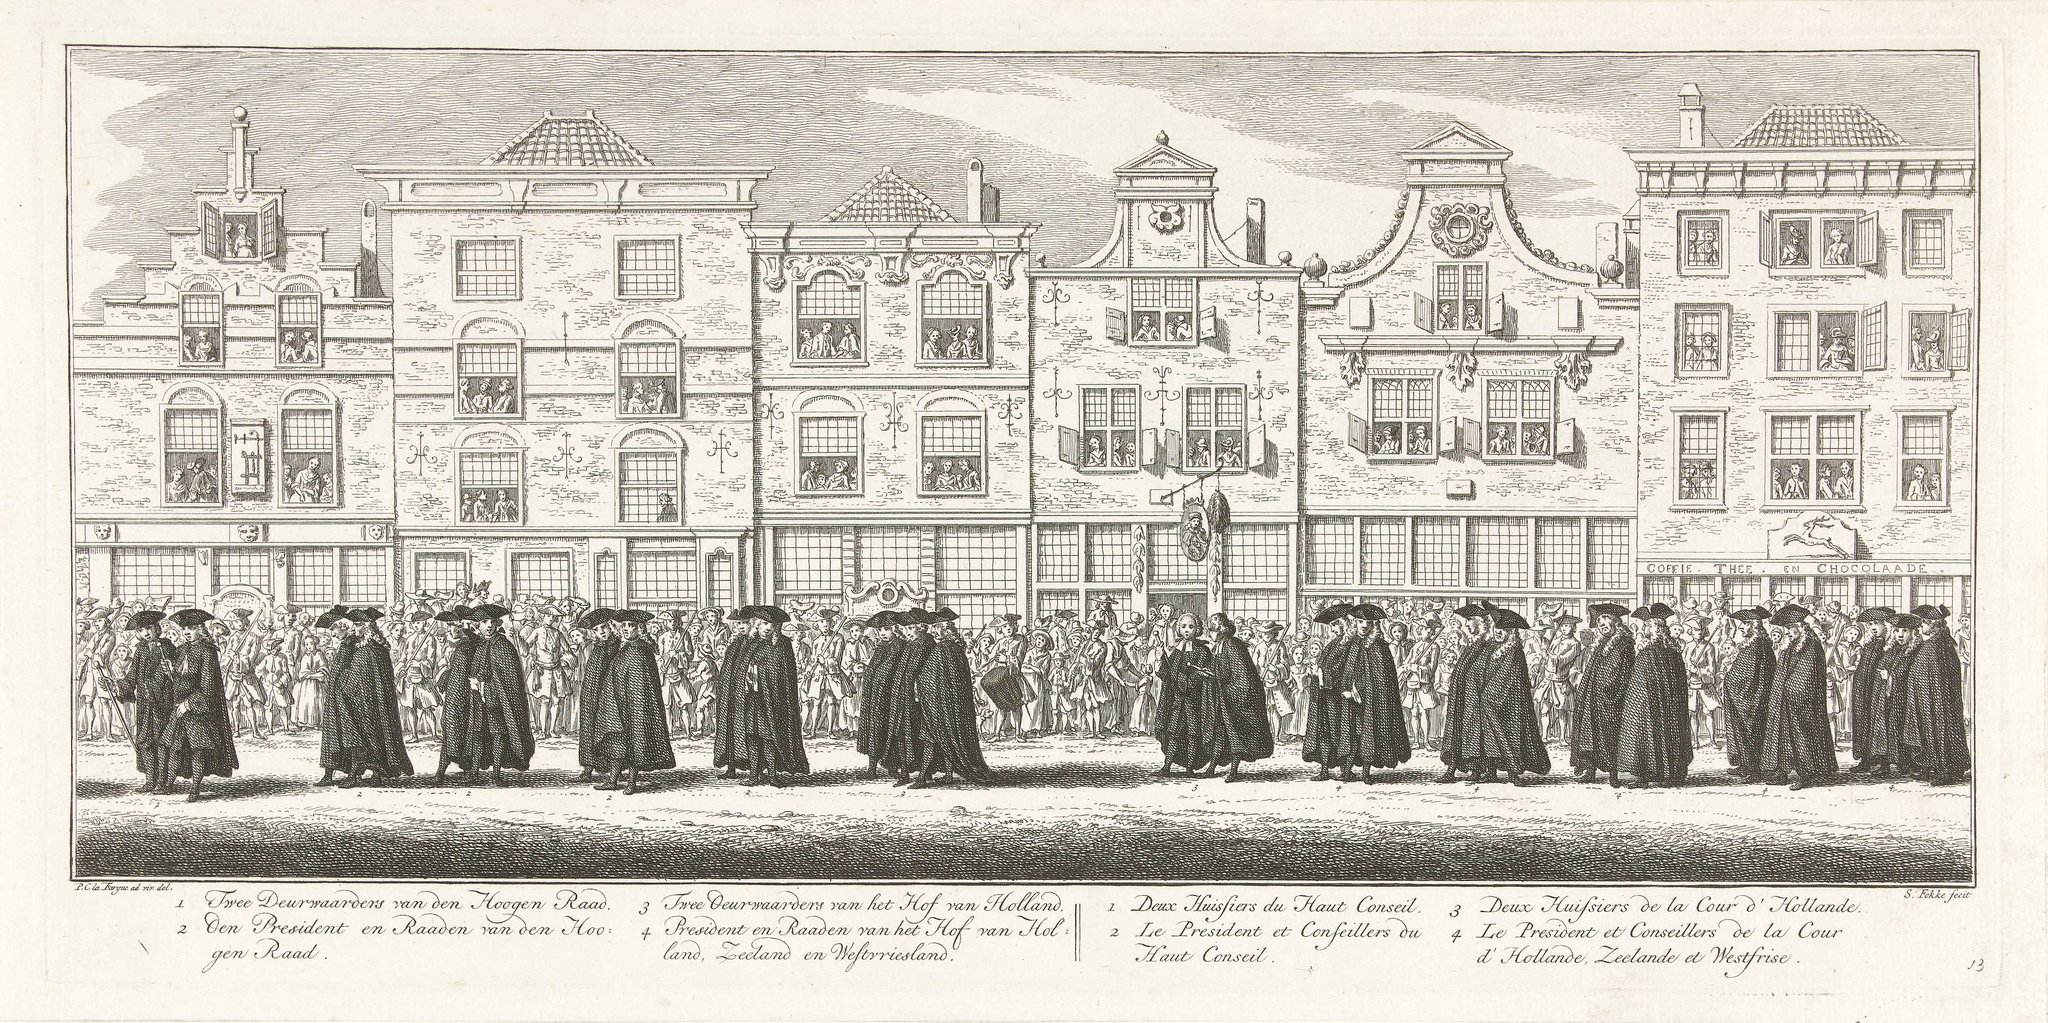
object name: print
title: Lijkstoet van prinses Anna van Hannover te Delft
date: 1759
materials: paper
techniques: engraving, etching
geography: northern netherlands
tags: the hague, anna van hannover, cortege, funeral procession, delft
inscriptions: collector's mark: Lugt 2228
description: Leden en personeel van de Hoge Raad en Hof van Holland. Onderdeel van een serie van 16 platen plus een gedrukte beschrijving van de lijkstatie van de op 23 februari 1759 te Delft begraven prinses Anna van Hannover. Genummerd rechtsonder: 13.